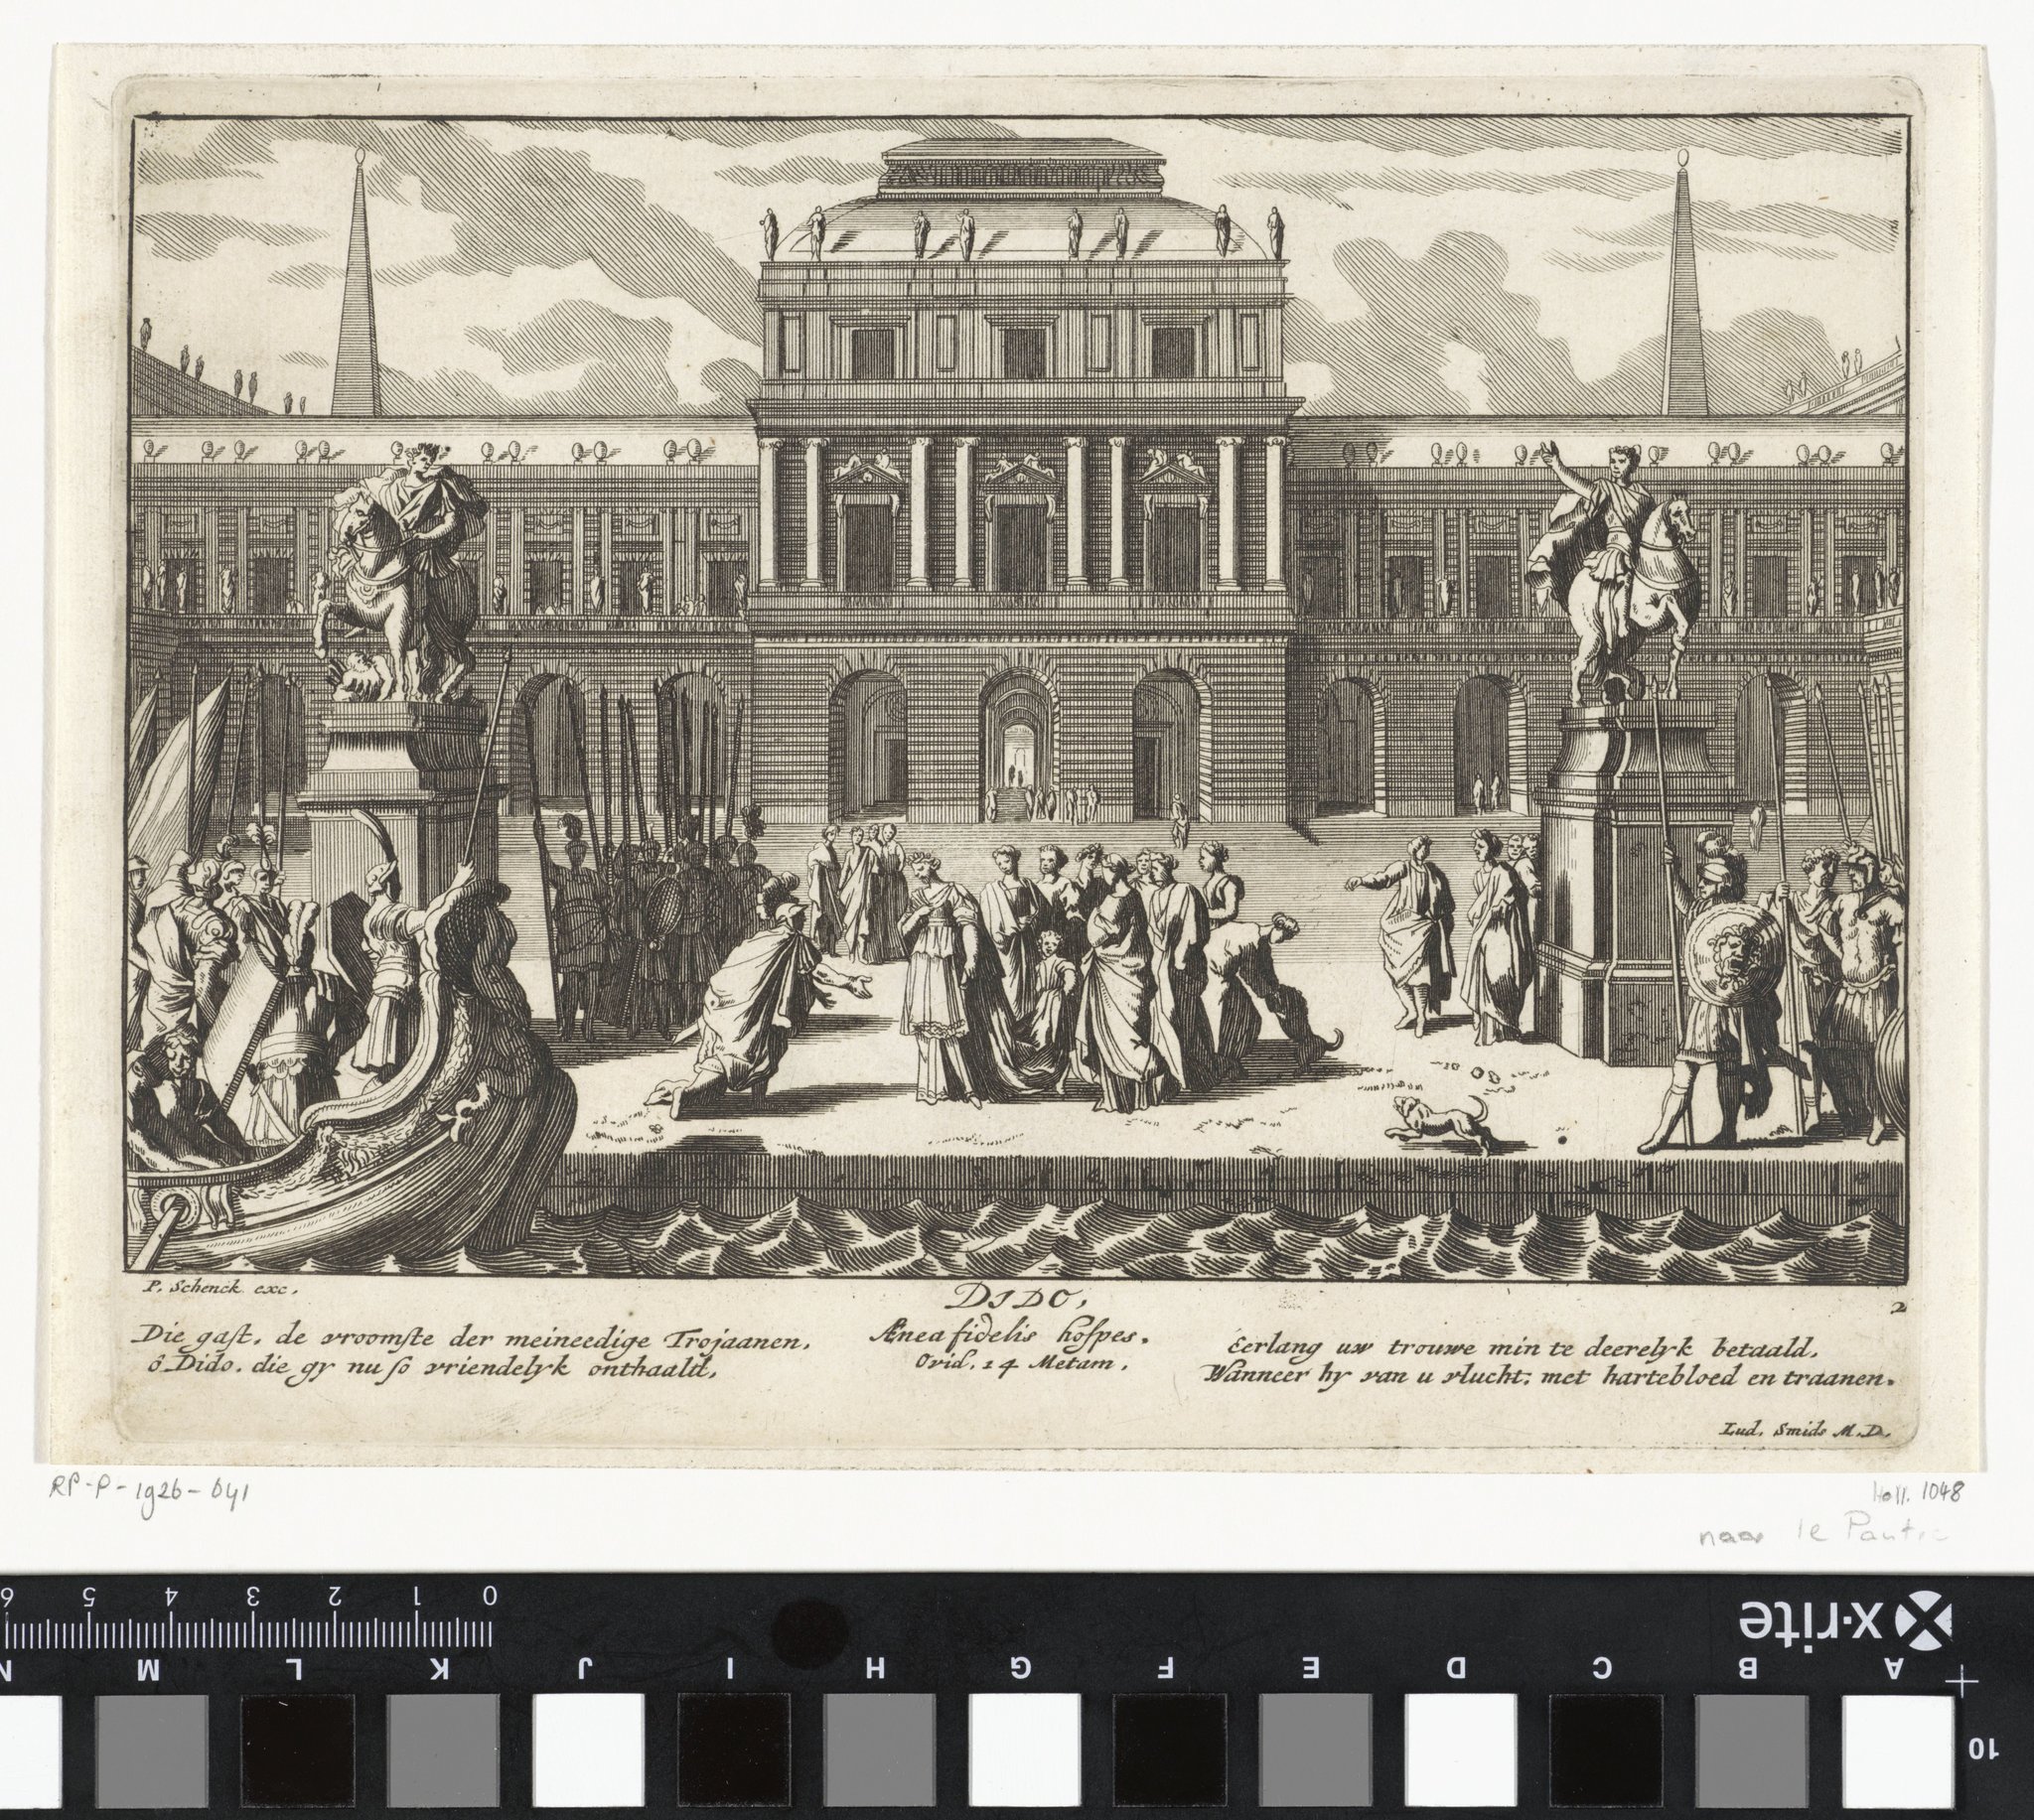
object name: print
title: Scenarum Theatralium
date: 1675-1711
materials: paper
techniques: engraving, etching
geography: amsterdam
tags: the meeting of aeneas and dido; when he approaches her throne, the cloud enveloping him and achates vanishes (+ variant)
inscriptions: collector's mark: Lugt 2166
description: Aeneas arriveert met zijn mannen en schepen in Carthago. Hij begroet en wordt verwelkomt door de stichteres van deze stad Dido, die gevolgd wordt door haar dienaressen. Onder de voorstelling een vierregelig vers in het Nederlands en een verwijzing naar de tekst in de Metamorfosen van Ovidius.